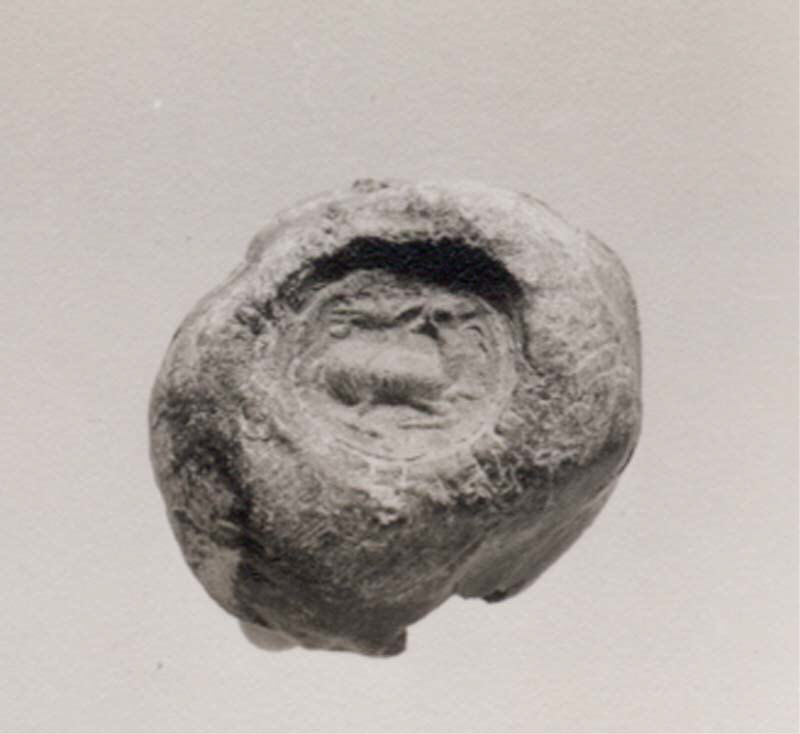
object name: sealing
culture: sasanian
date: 601-700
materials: clay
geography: iran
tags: animals